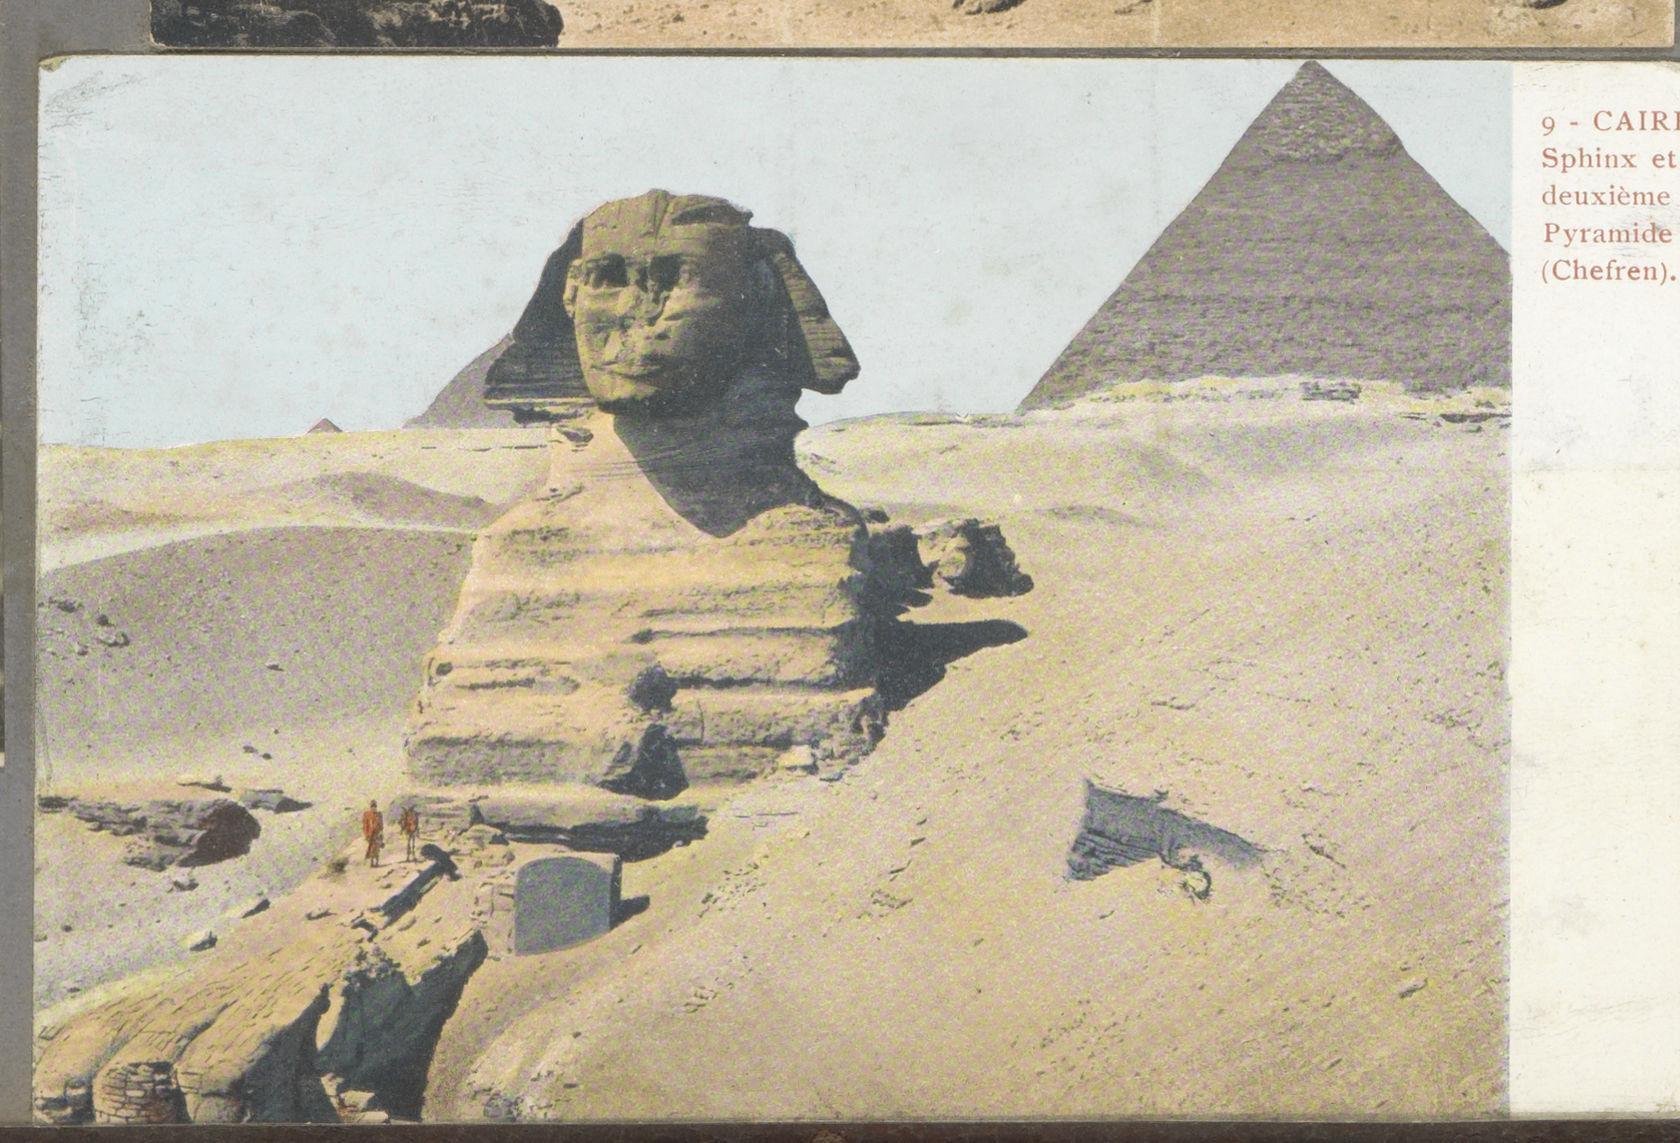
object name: ansichtkaart, prentbriefkaart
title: Gezicht op de sfinx en de piramide van Chefren bij Caïro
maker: Anonymous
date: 1895-1905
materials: paper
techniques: autotype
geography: cairo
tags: sphinx (lion/woman); 'sfinge' (ripa) - aa - female human figure, pyramid (historical grave form)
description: Onderdeel van Reisalbum met foto's van bezienswaardigheden in Griekenland en Egypte.